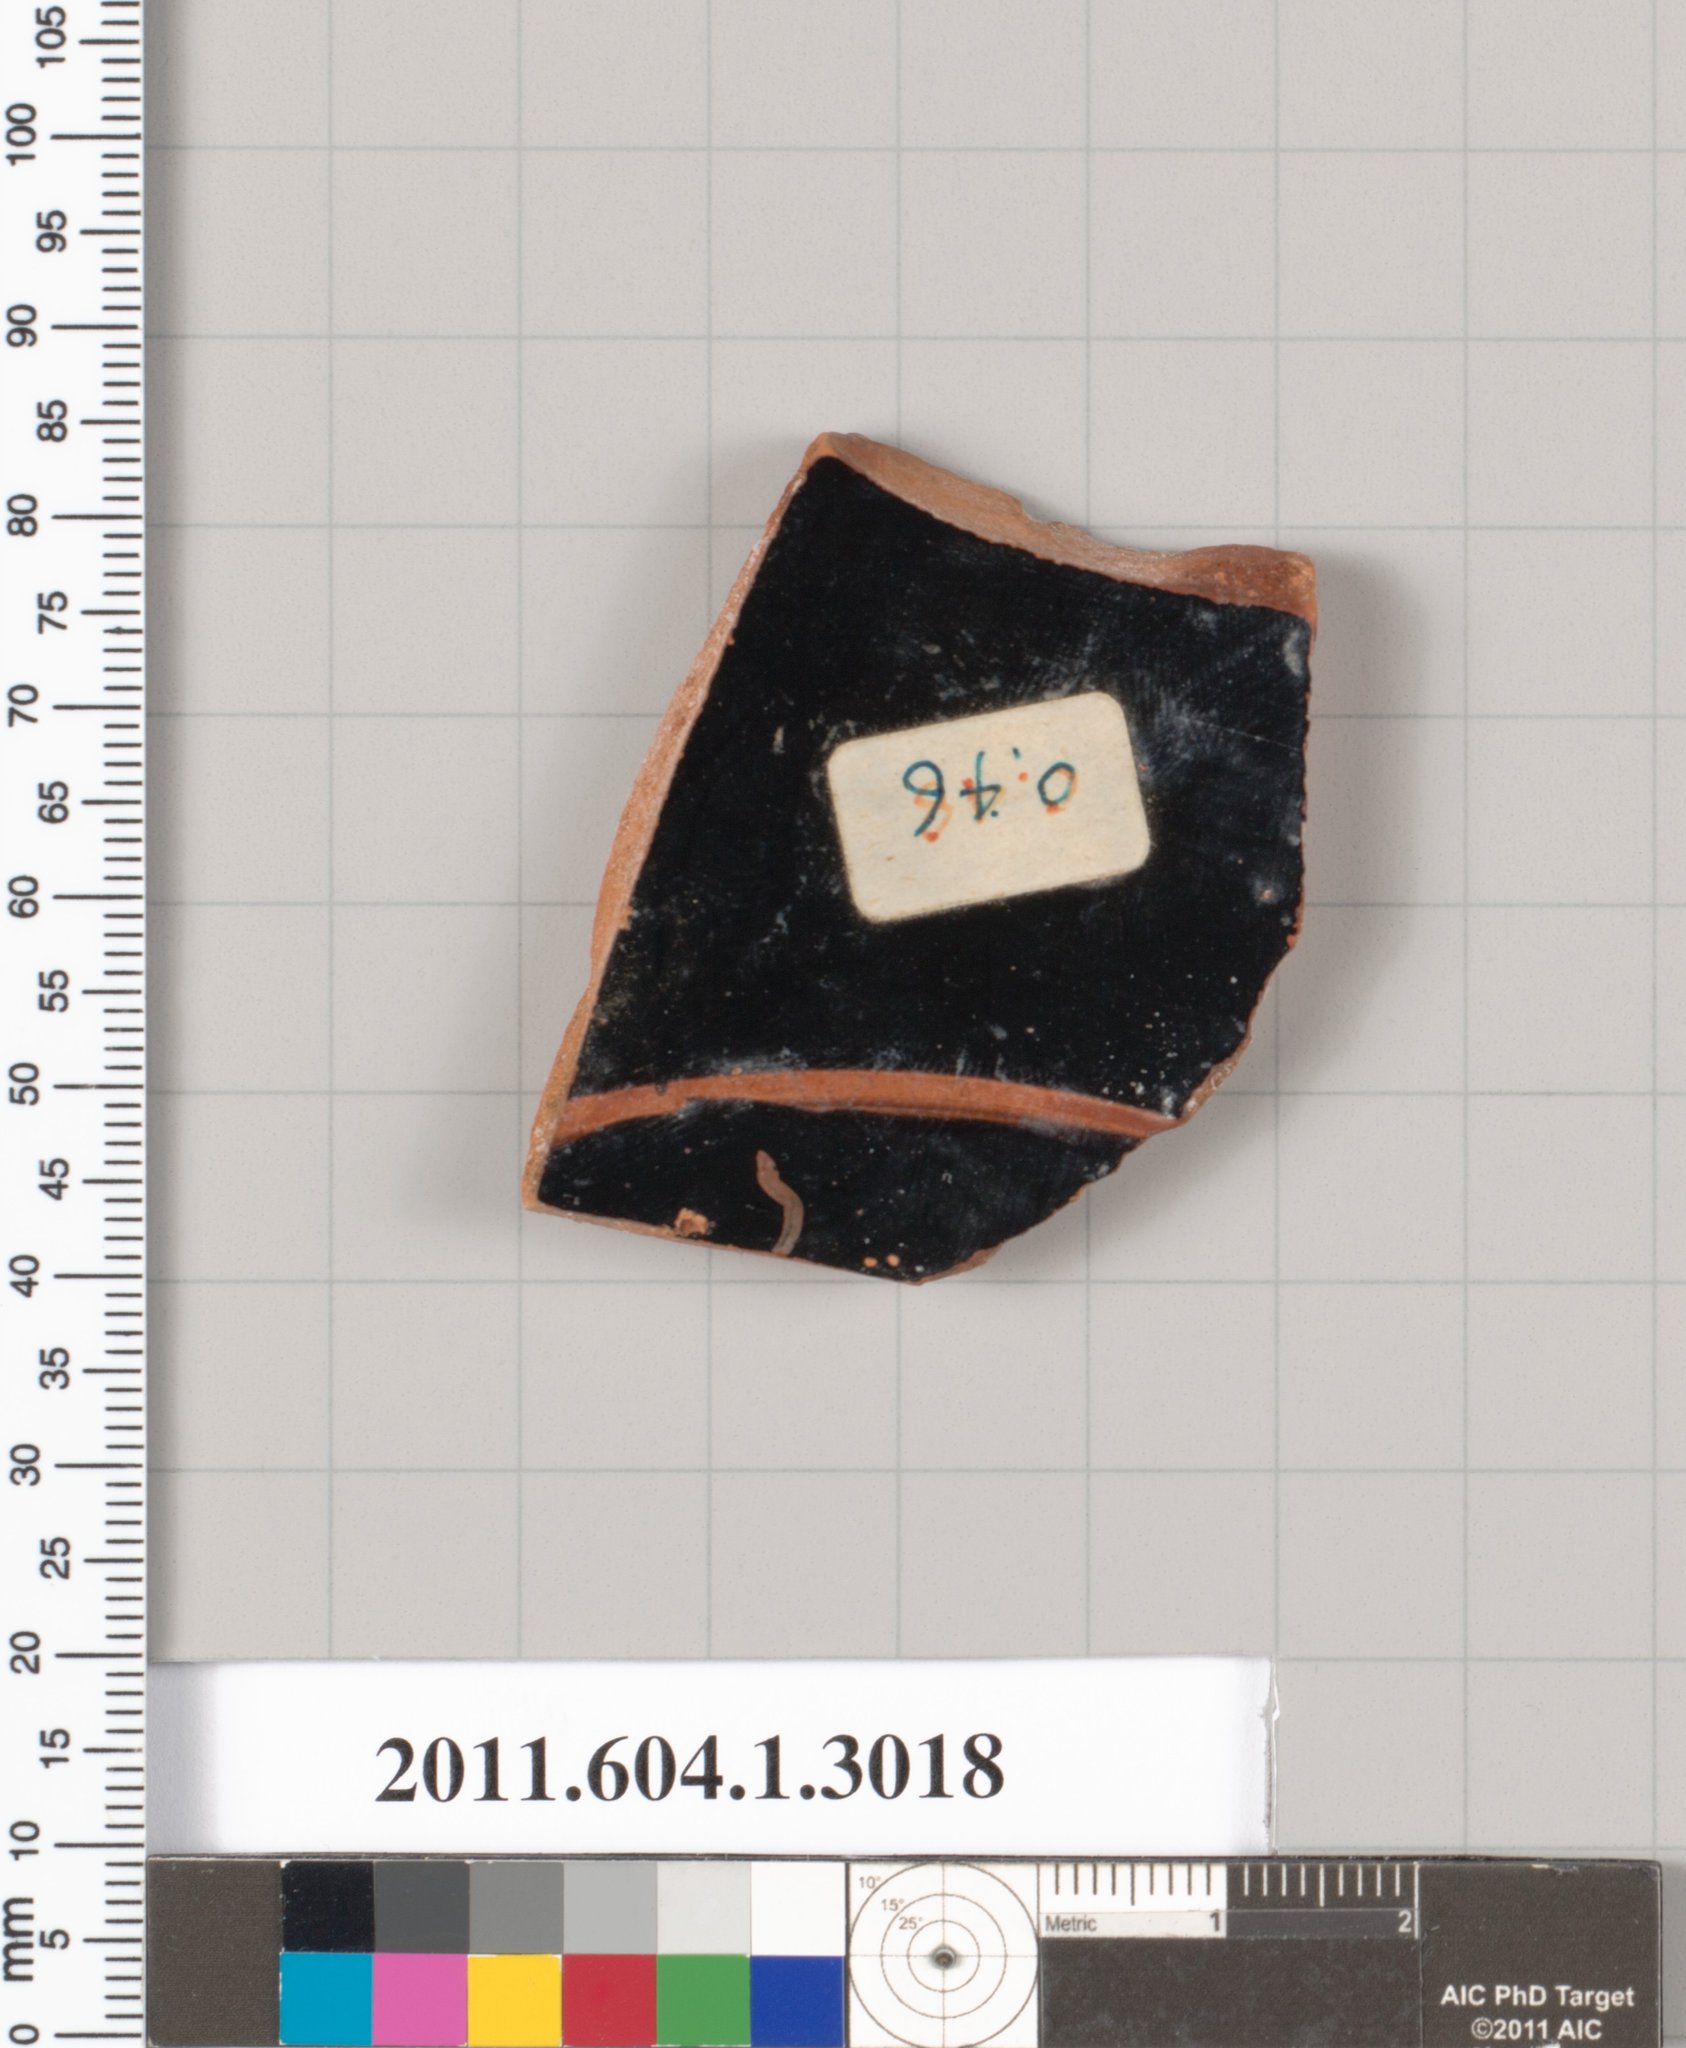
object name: kylix fragment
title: Terracotta fragment of a kylix (drinking cup)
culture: greek, attic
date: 520-500 BCE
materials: terracotta